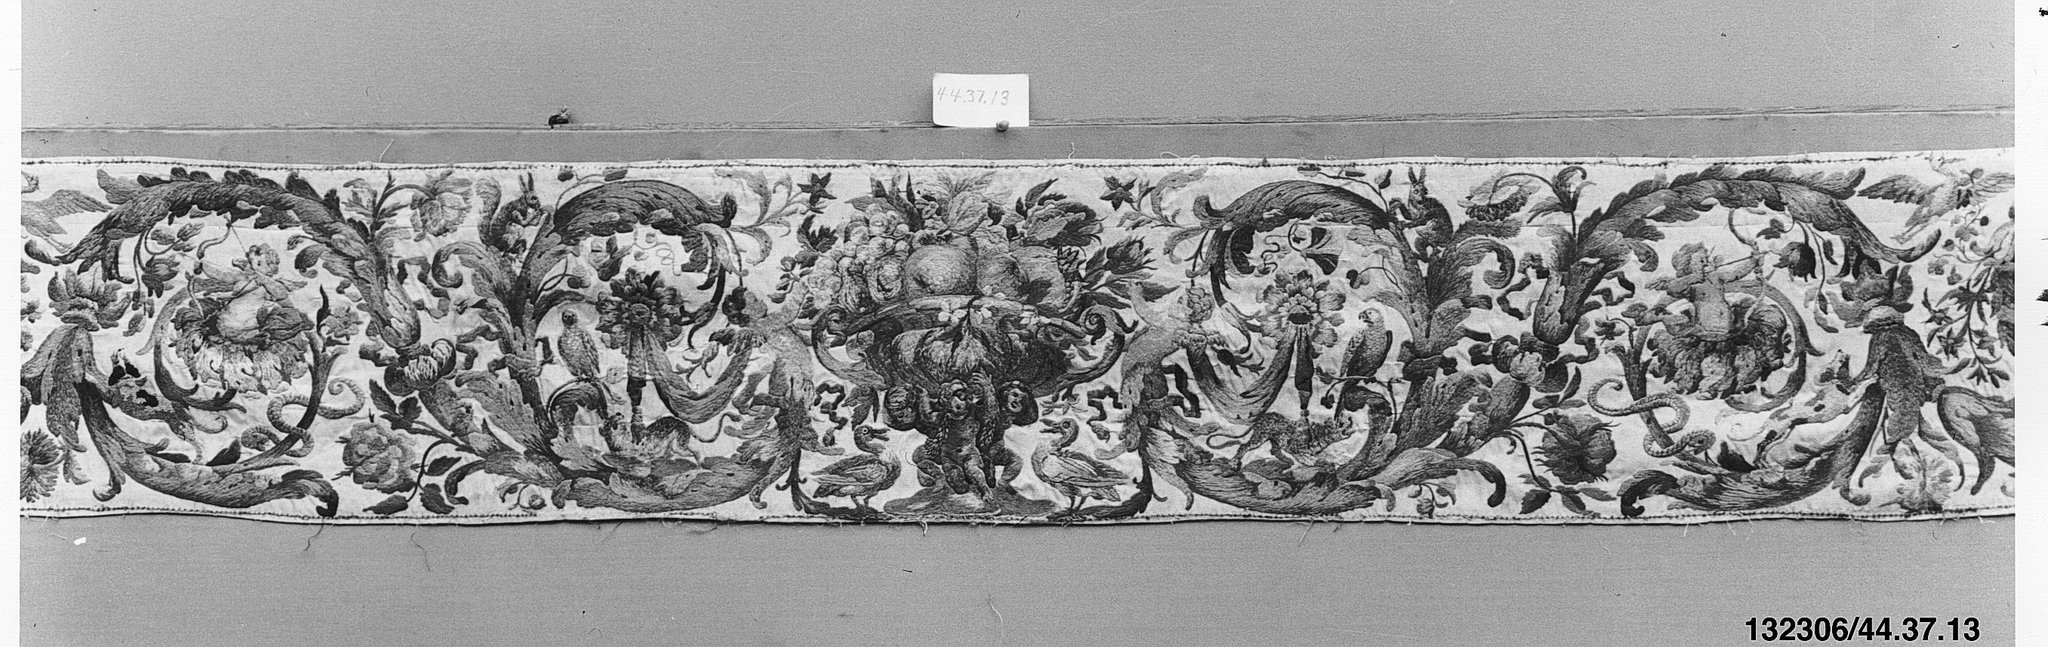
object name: valance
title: Valance (one of a set of six)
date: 1667-1733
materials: silk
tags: birds,flowers